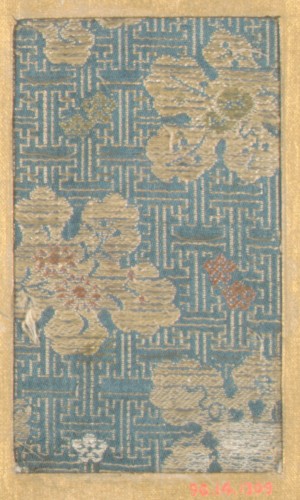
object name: piece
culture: japanese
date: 1701-1900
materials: silk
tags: flowers